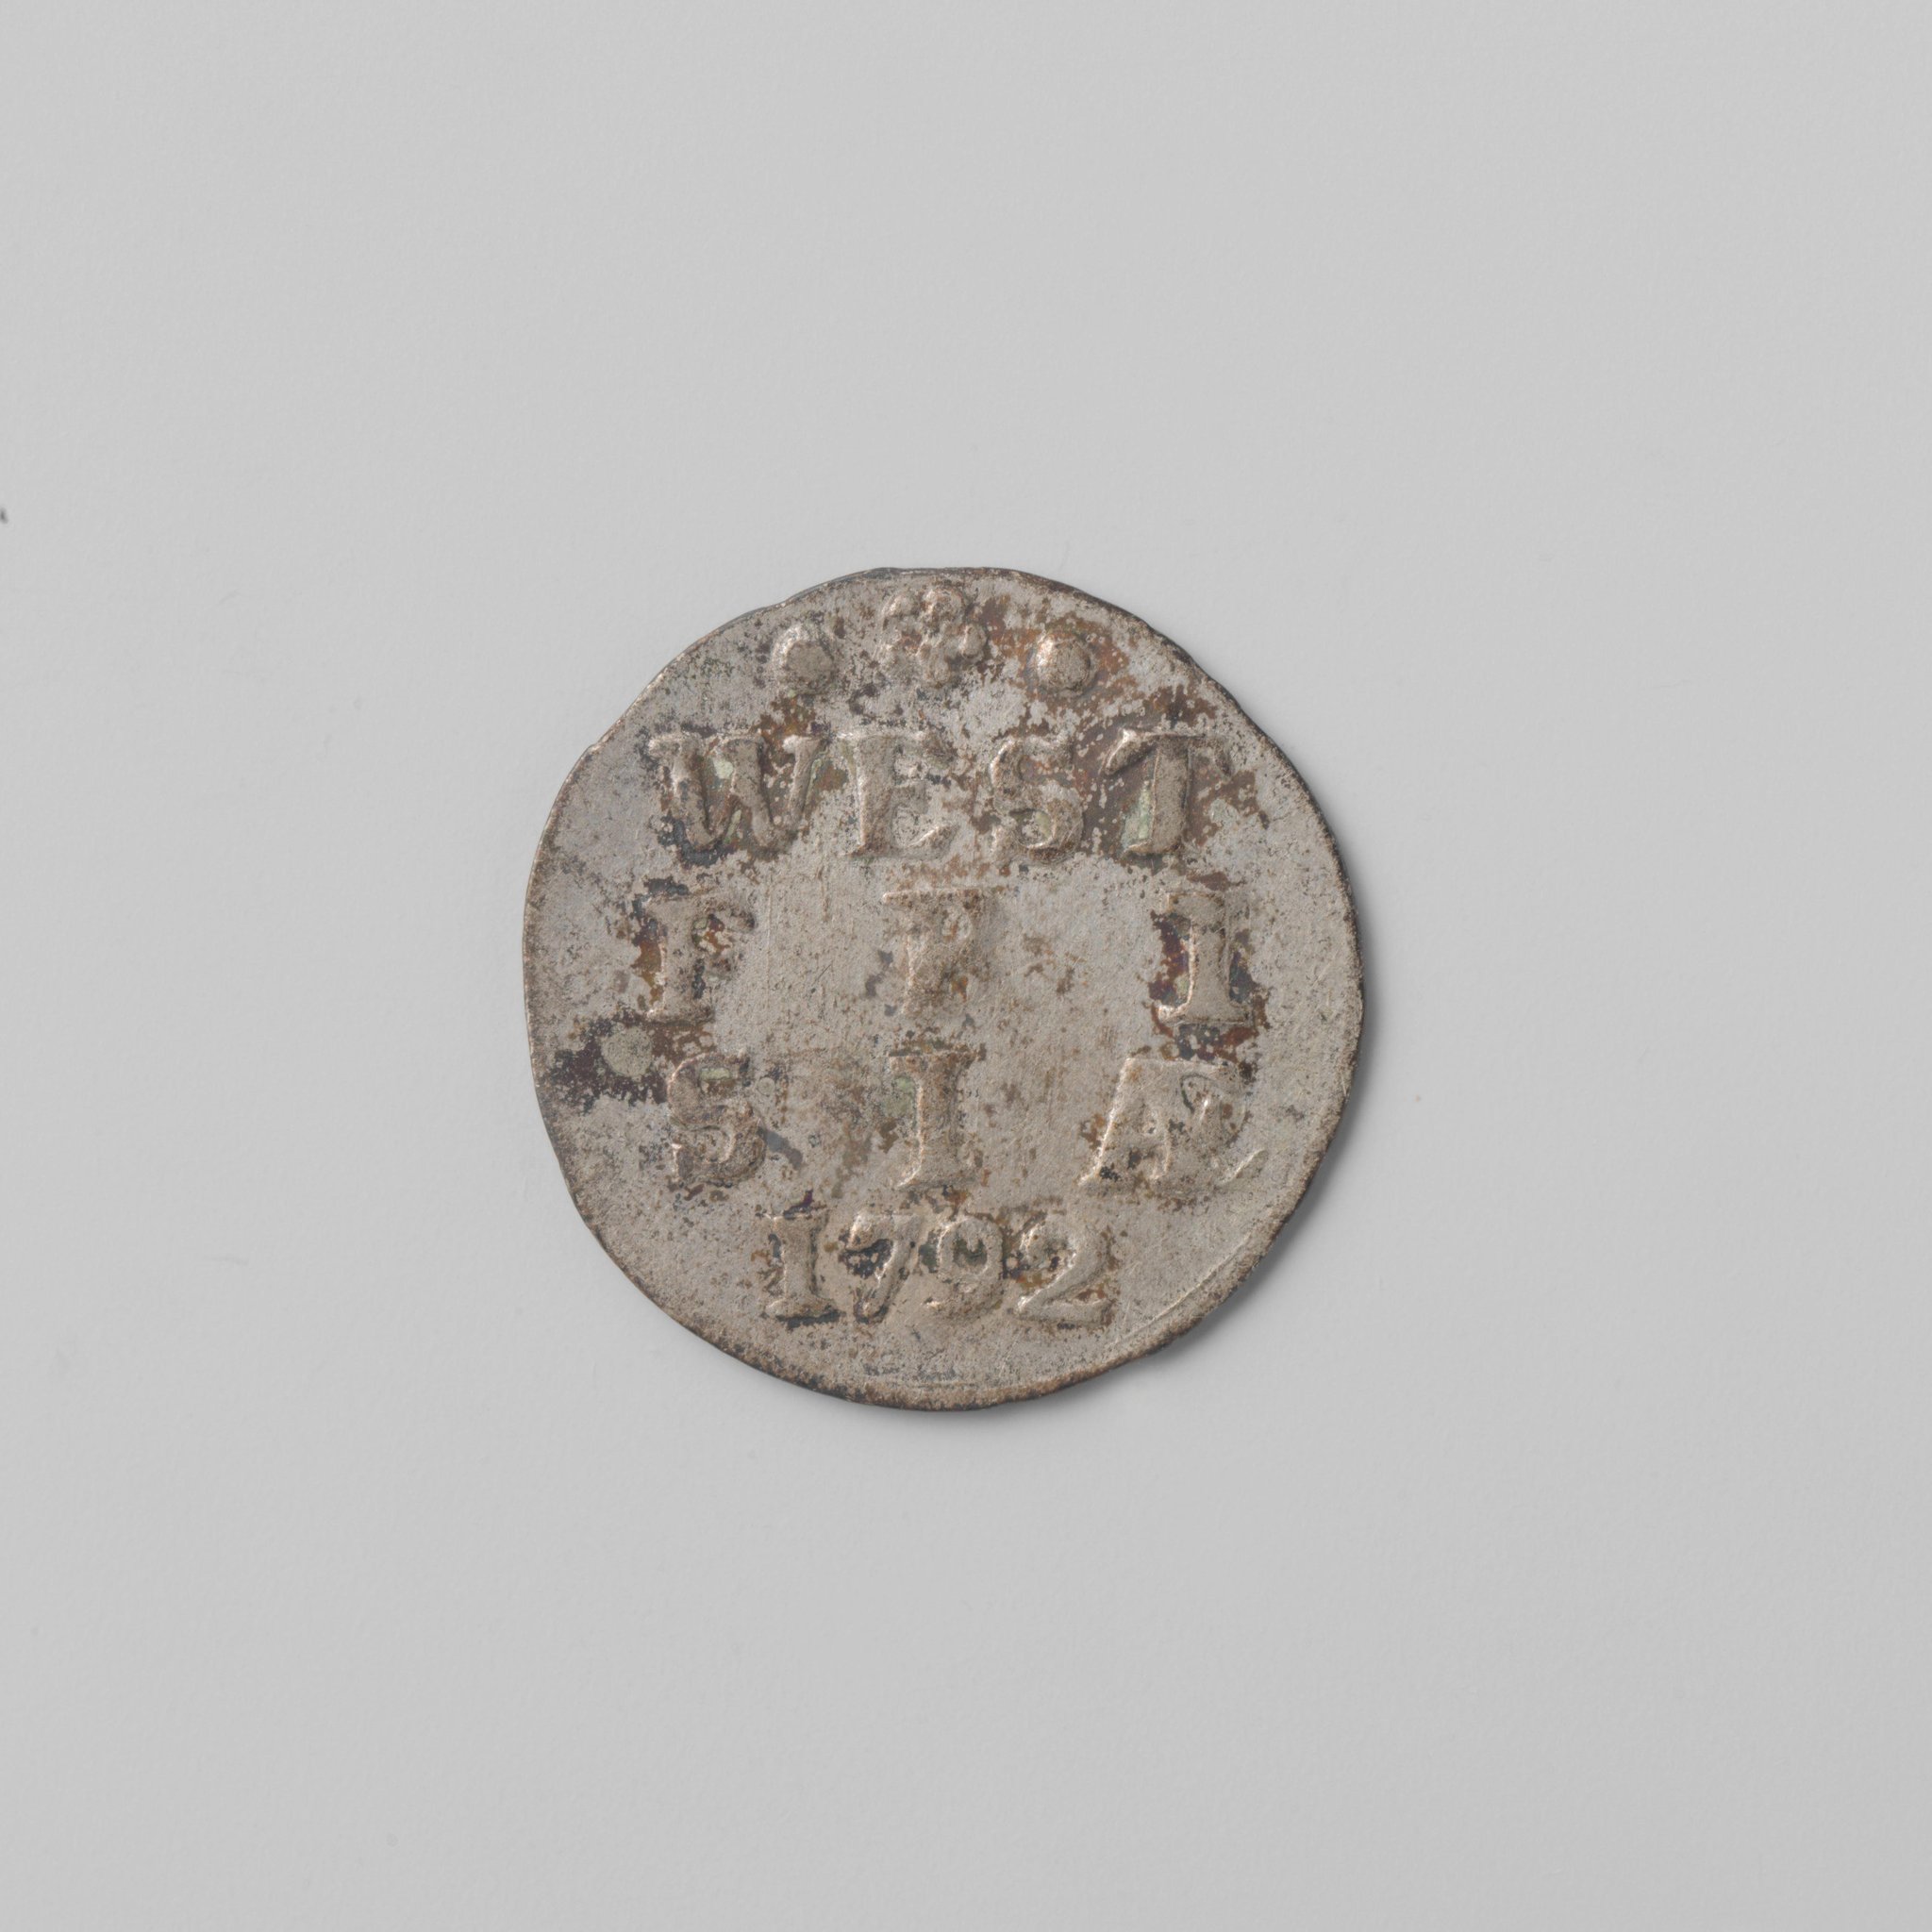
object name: coin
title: West-Friesland, dubbele stuiver, 1792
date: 1792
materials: silver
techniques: striking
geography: west frisia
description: Zilveren munt. Voorzijde: tussen waarde-aanduiding 2 S gekroond wapenschild van West-Friesland. Keerzijde: opschrift in drie regels. Daarboven muntteken tussen twee punten, daaronder jaartal.